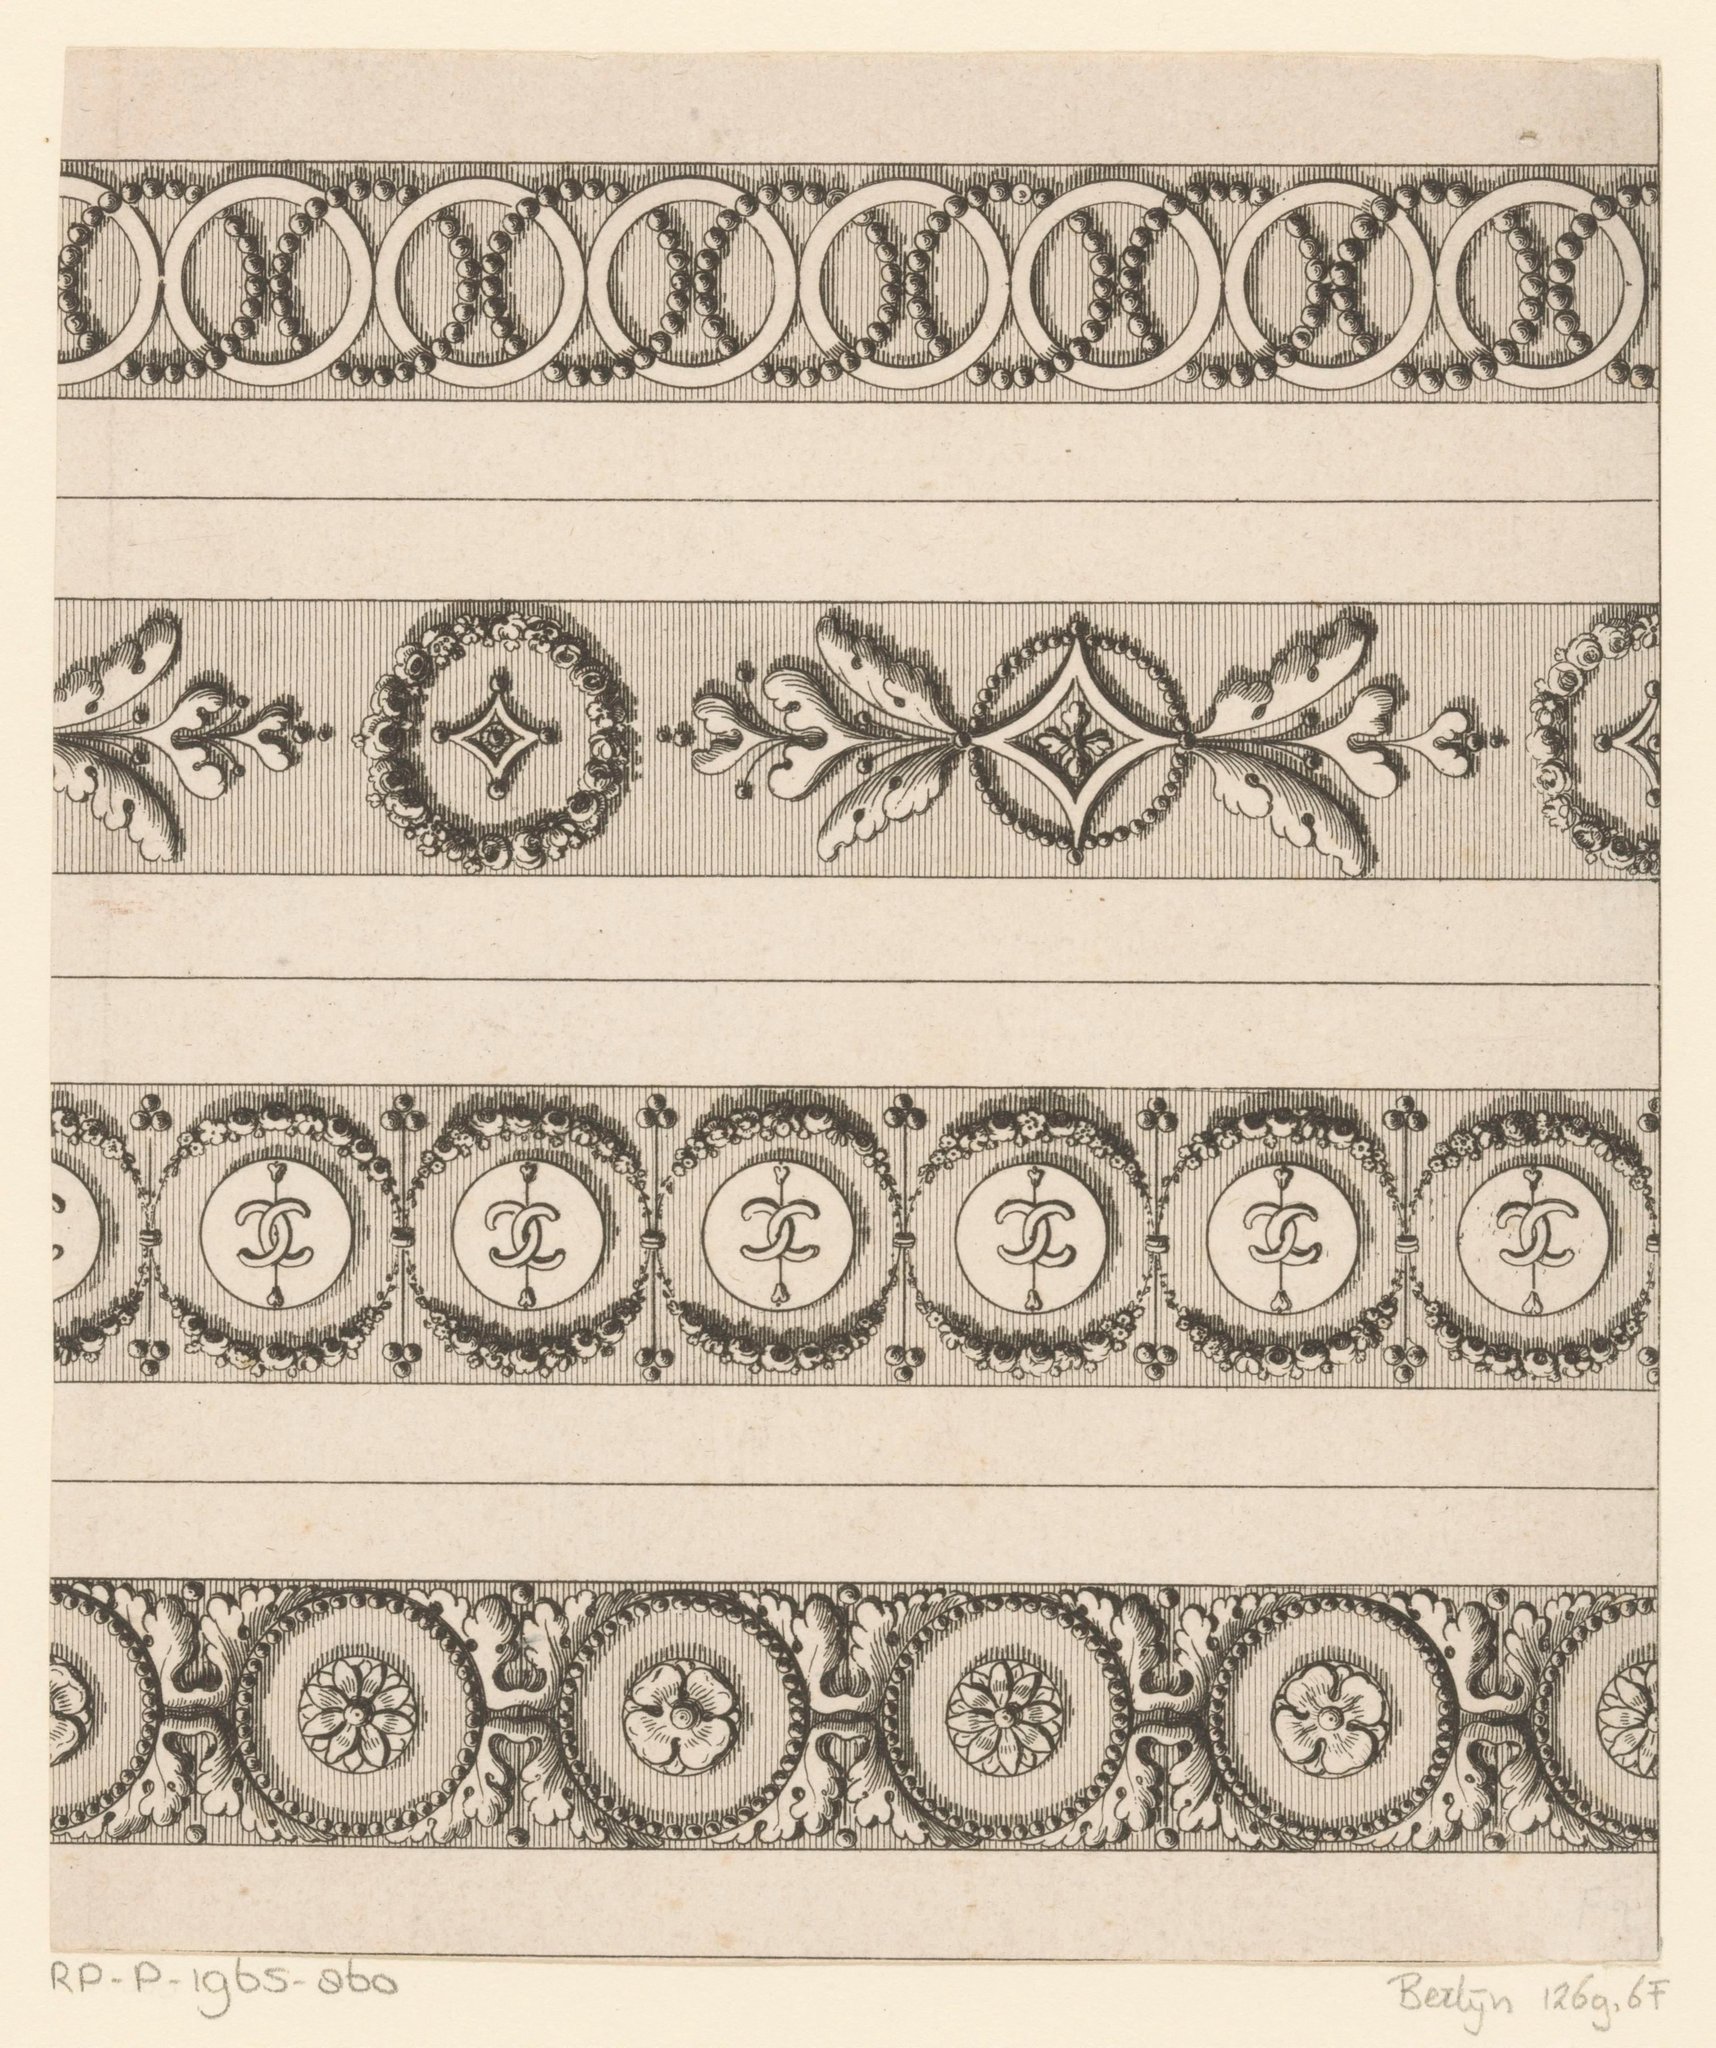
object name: ornament print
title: F Cahier de petites Bordures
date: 1784-1785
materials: paper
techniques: engraving, etching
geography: paris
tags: ornaments ~ art (+ framing decorations)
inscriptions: collector's mark: Lugt 2760, collector's mark: Lugt 2228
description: Vier geornamenteerde randen met ronde elementen, blad- en bloemmotieven en medaillons.